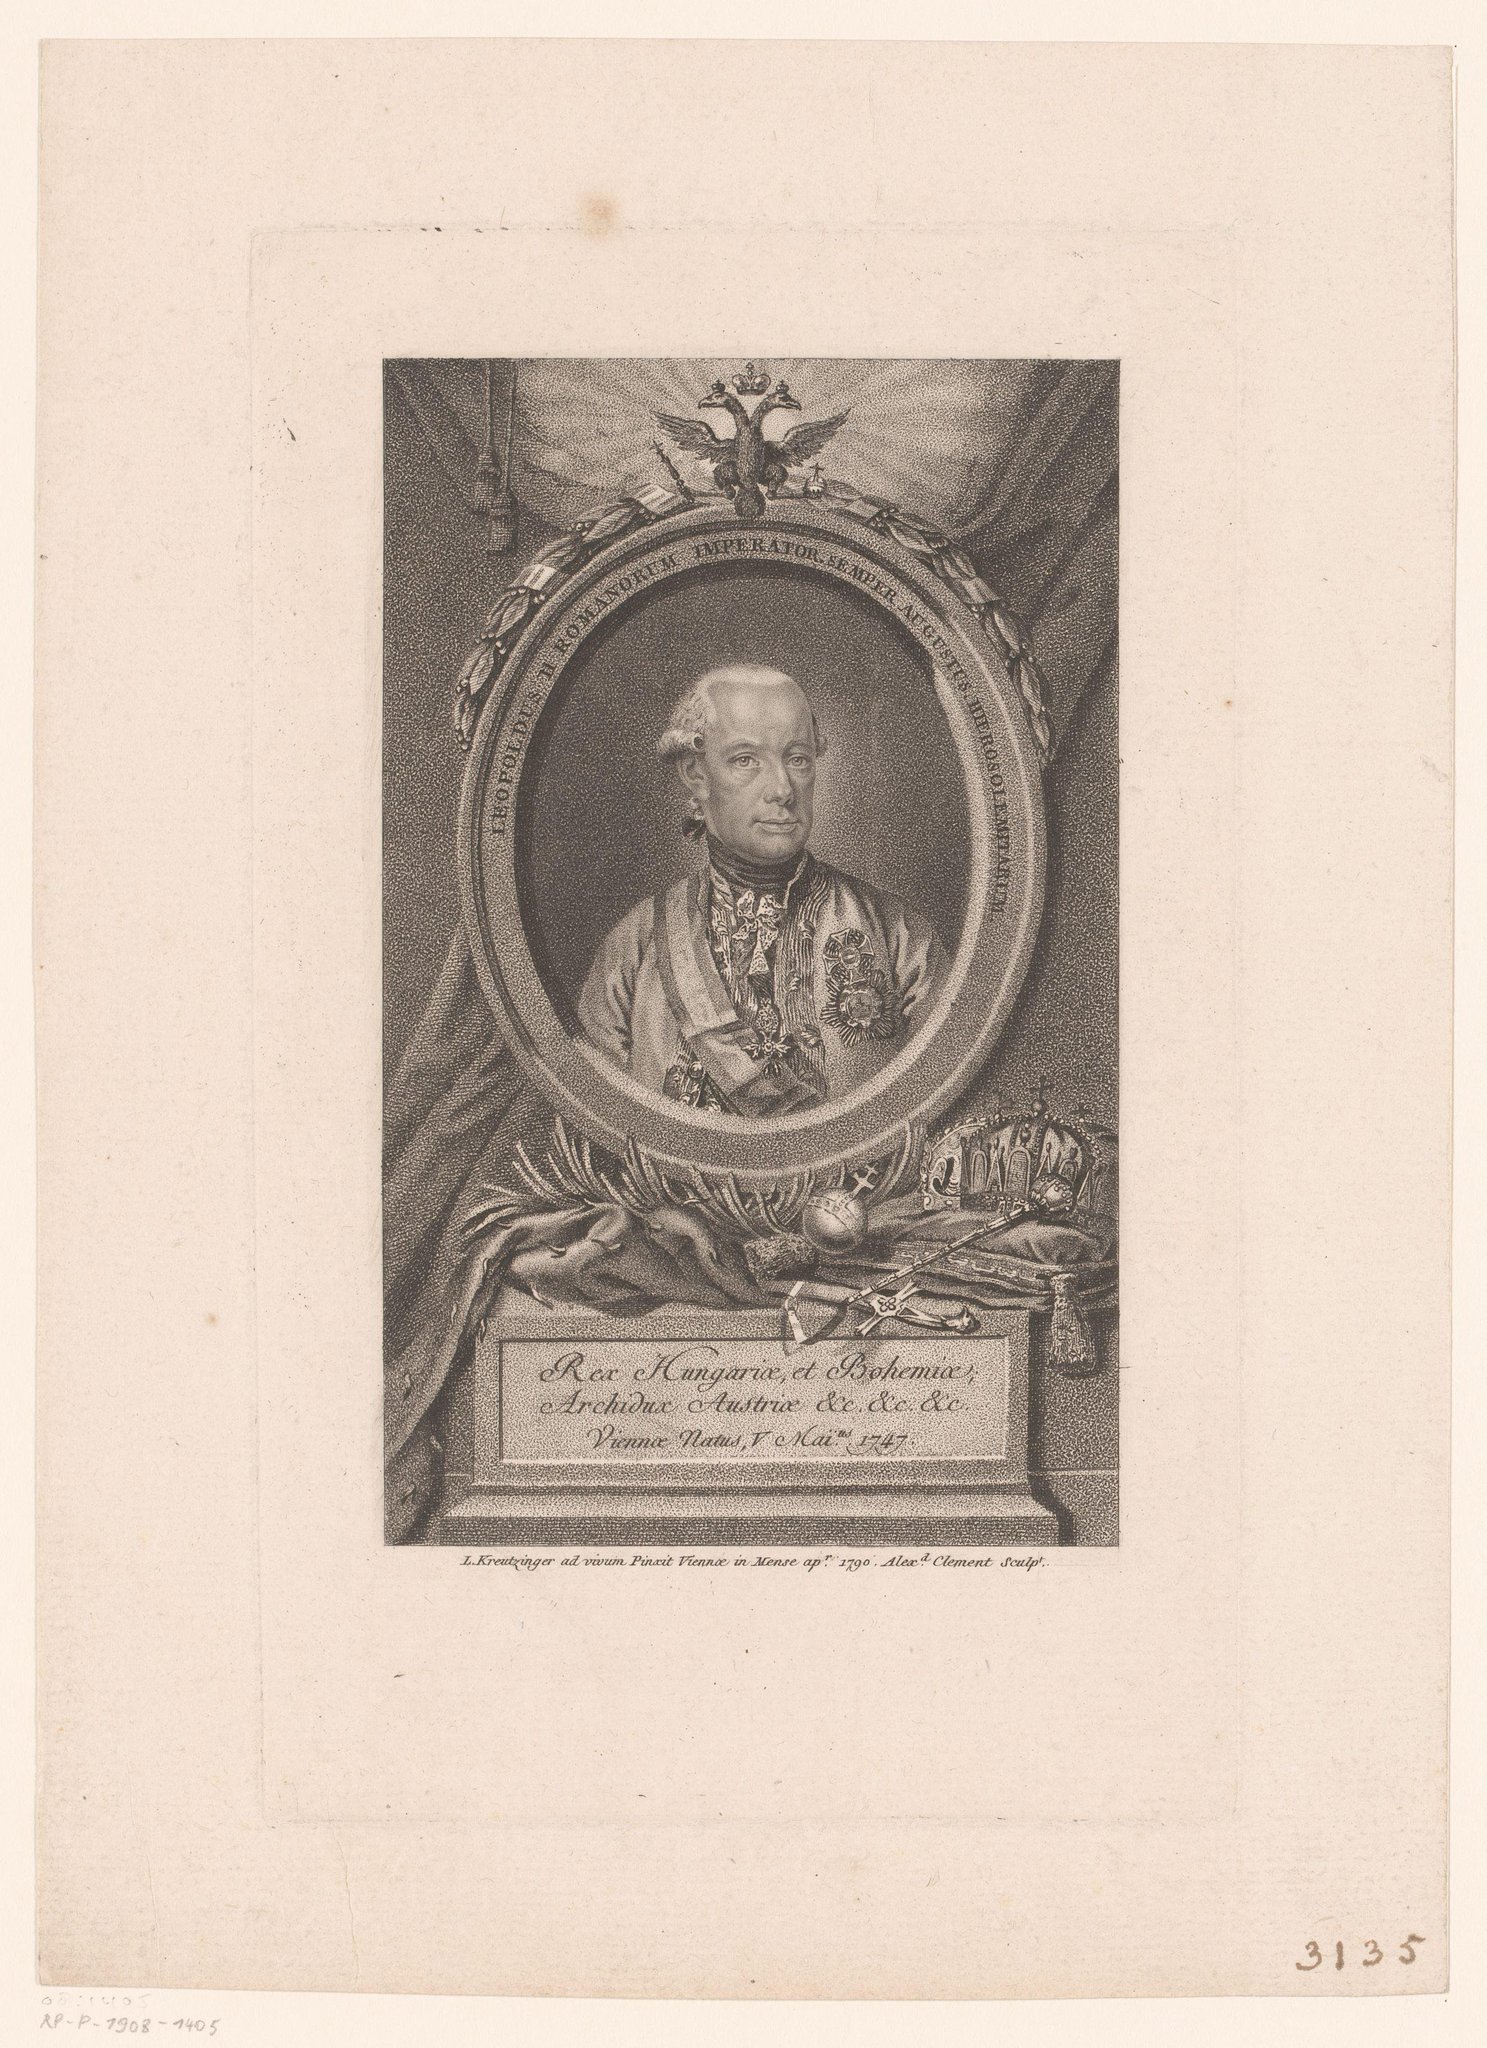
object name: print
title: Leopoldus II romanorum imperator (...)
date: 1805-1848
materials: paper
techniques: stippling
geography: france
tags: leopold ii (keizer van oostenrijk), ornament ~ medallion, historical persons, ruler, sovereign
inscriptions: collector's mark: Lugt 2228